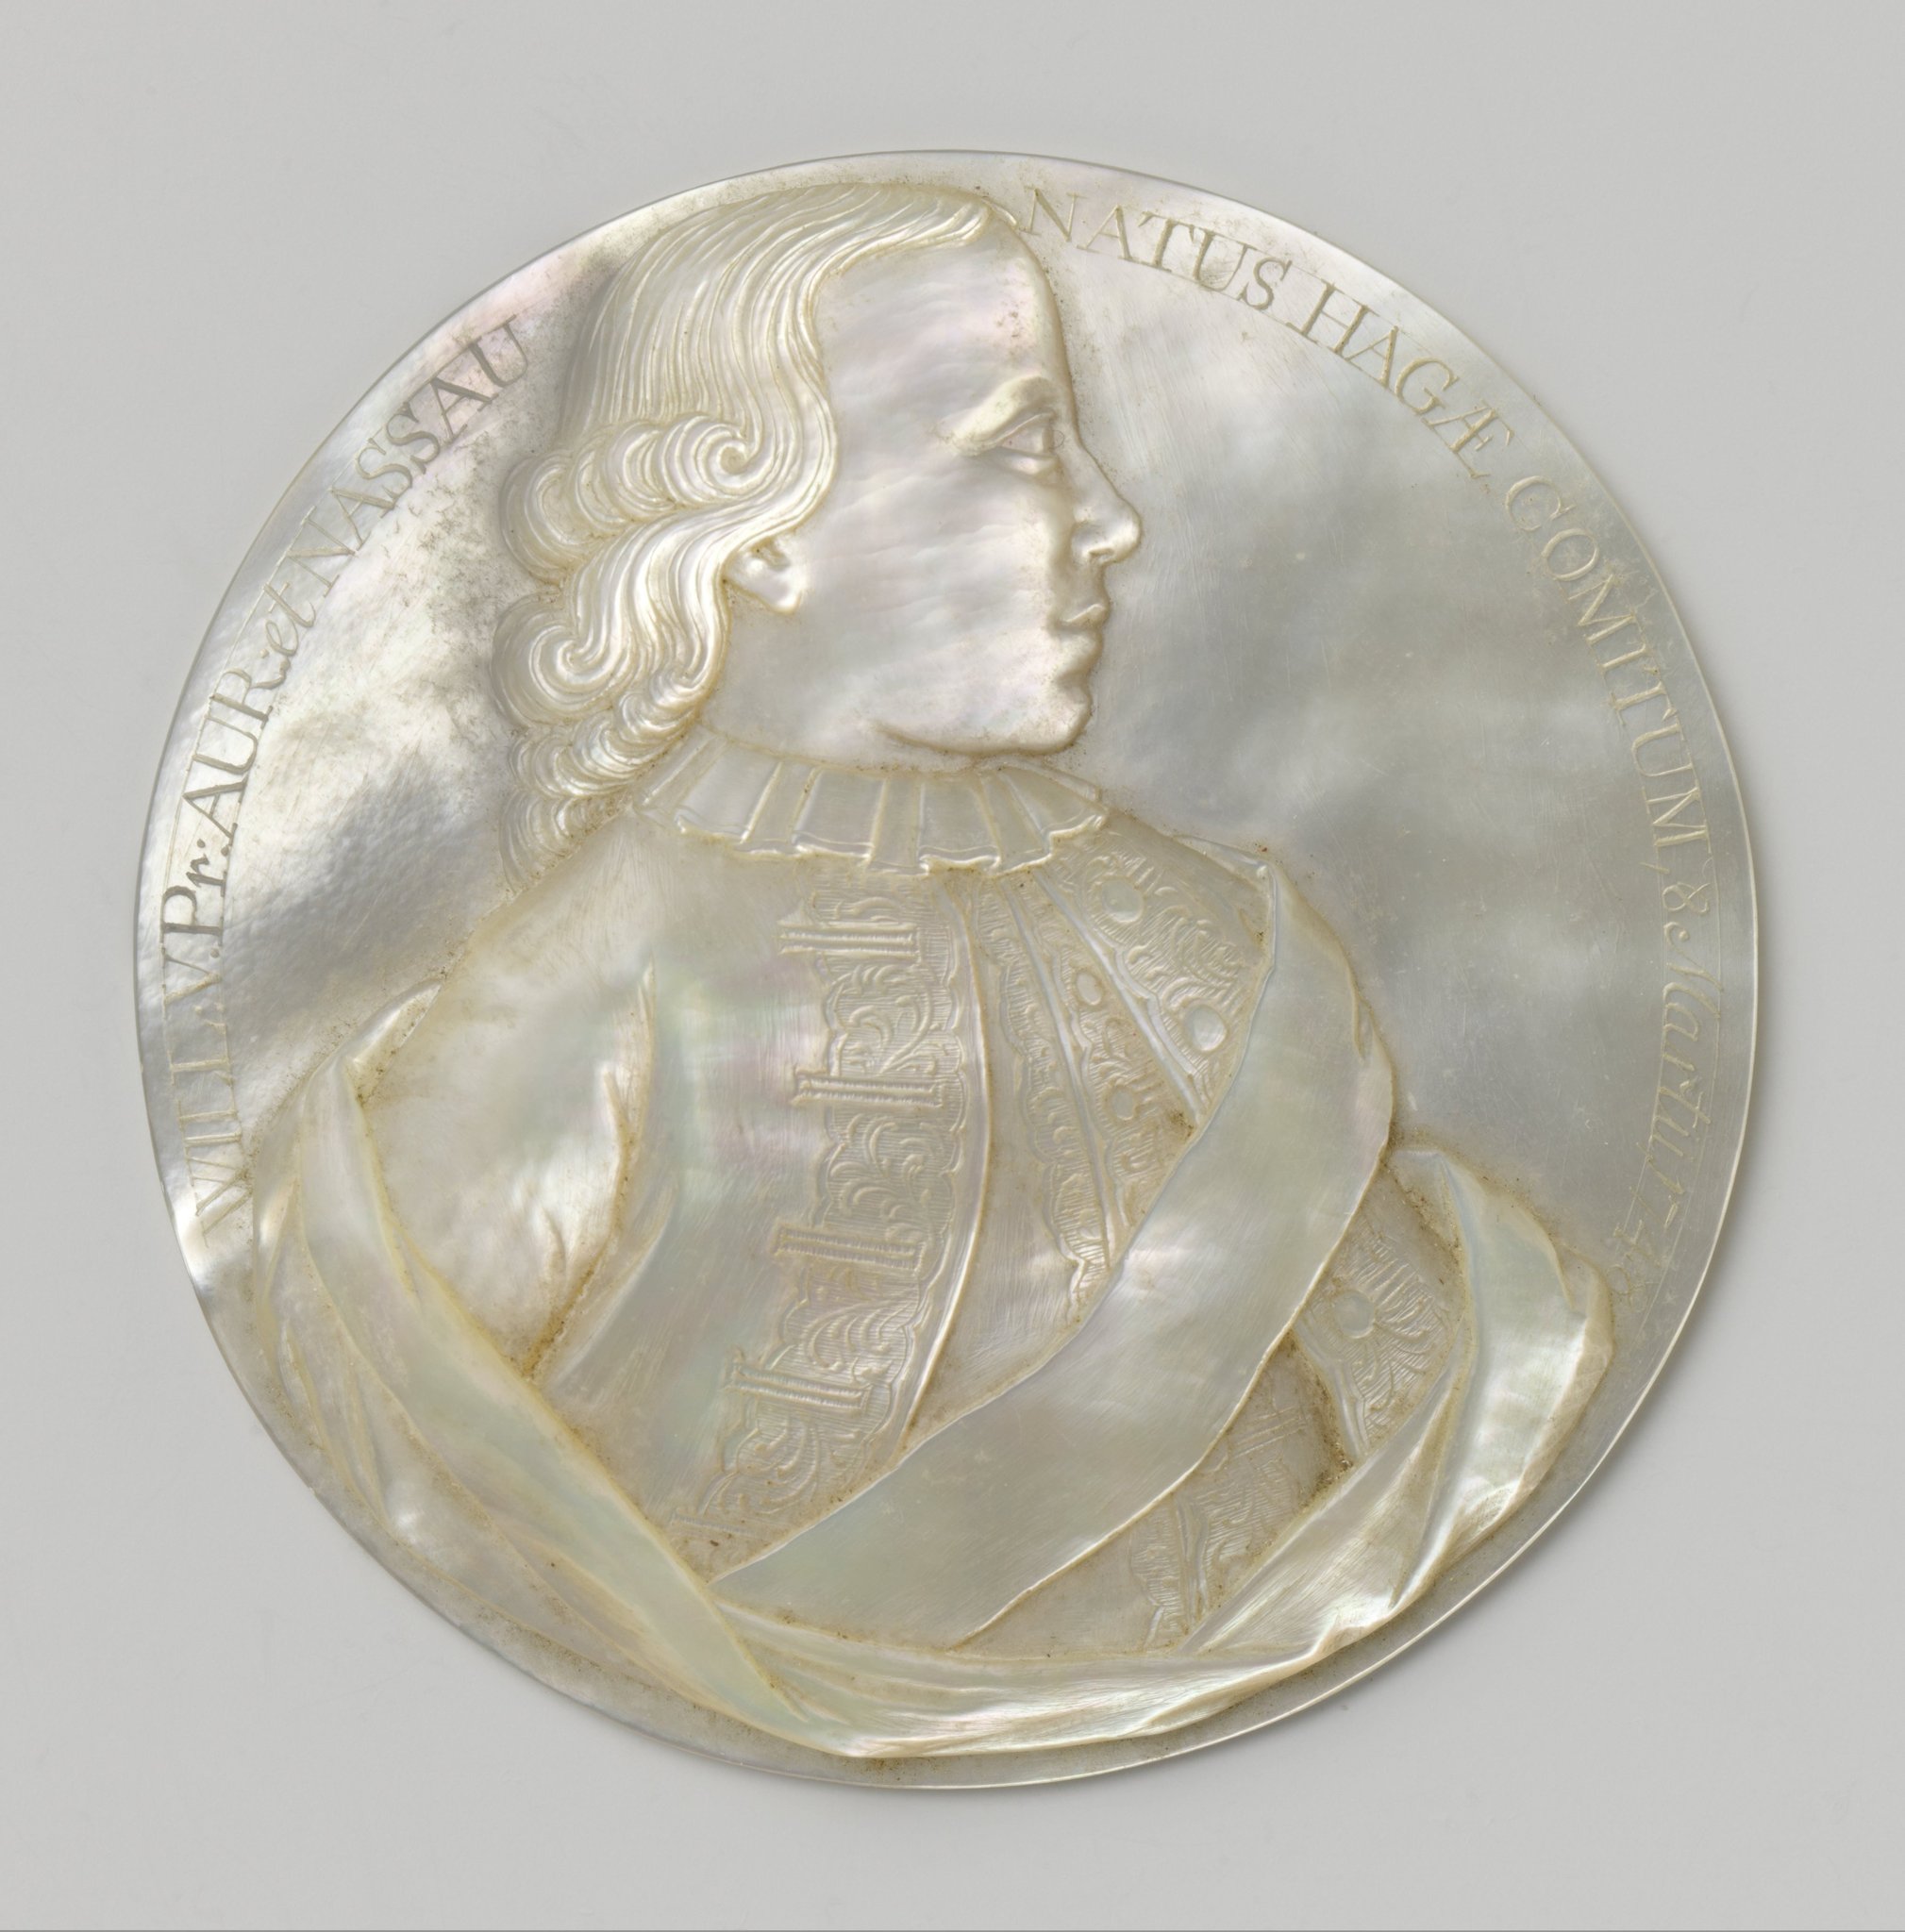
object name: portretmedaillon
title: Portret van Willem V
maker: johannes christiaan konsé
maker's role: jeweler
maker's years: 1700-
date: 1757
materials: mother of pearl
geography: amsterdam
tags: the hague, william v (prince of orange)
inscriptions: date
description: Een portret van Prins Willem V als kind van negen jaar. Medaillon in parelmoer. Randschrift: WILLEM V, PRINS ....Op de achterkant J.C.Konse fec 1757. Pendant van BK-NM-250.